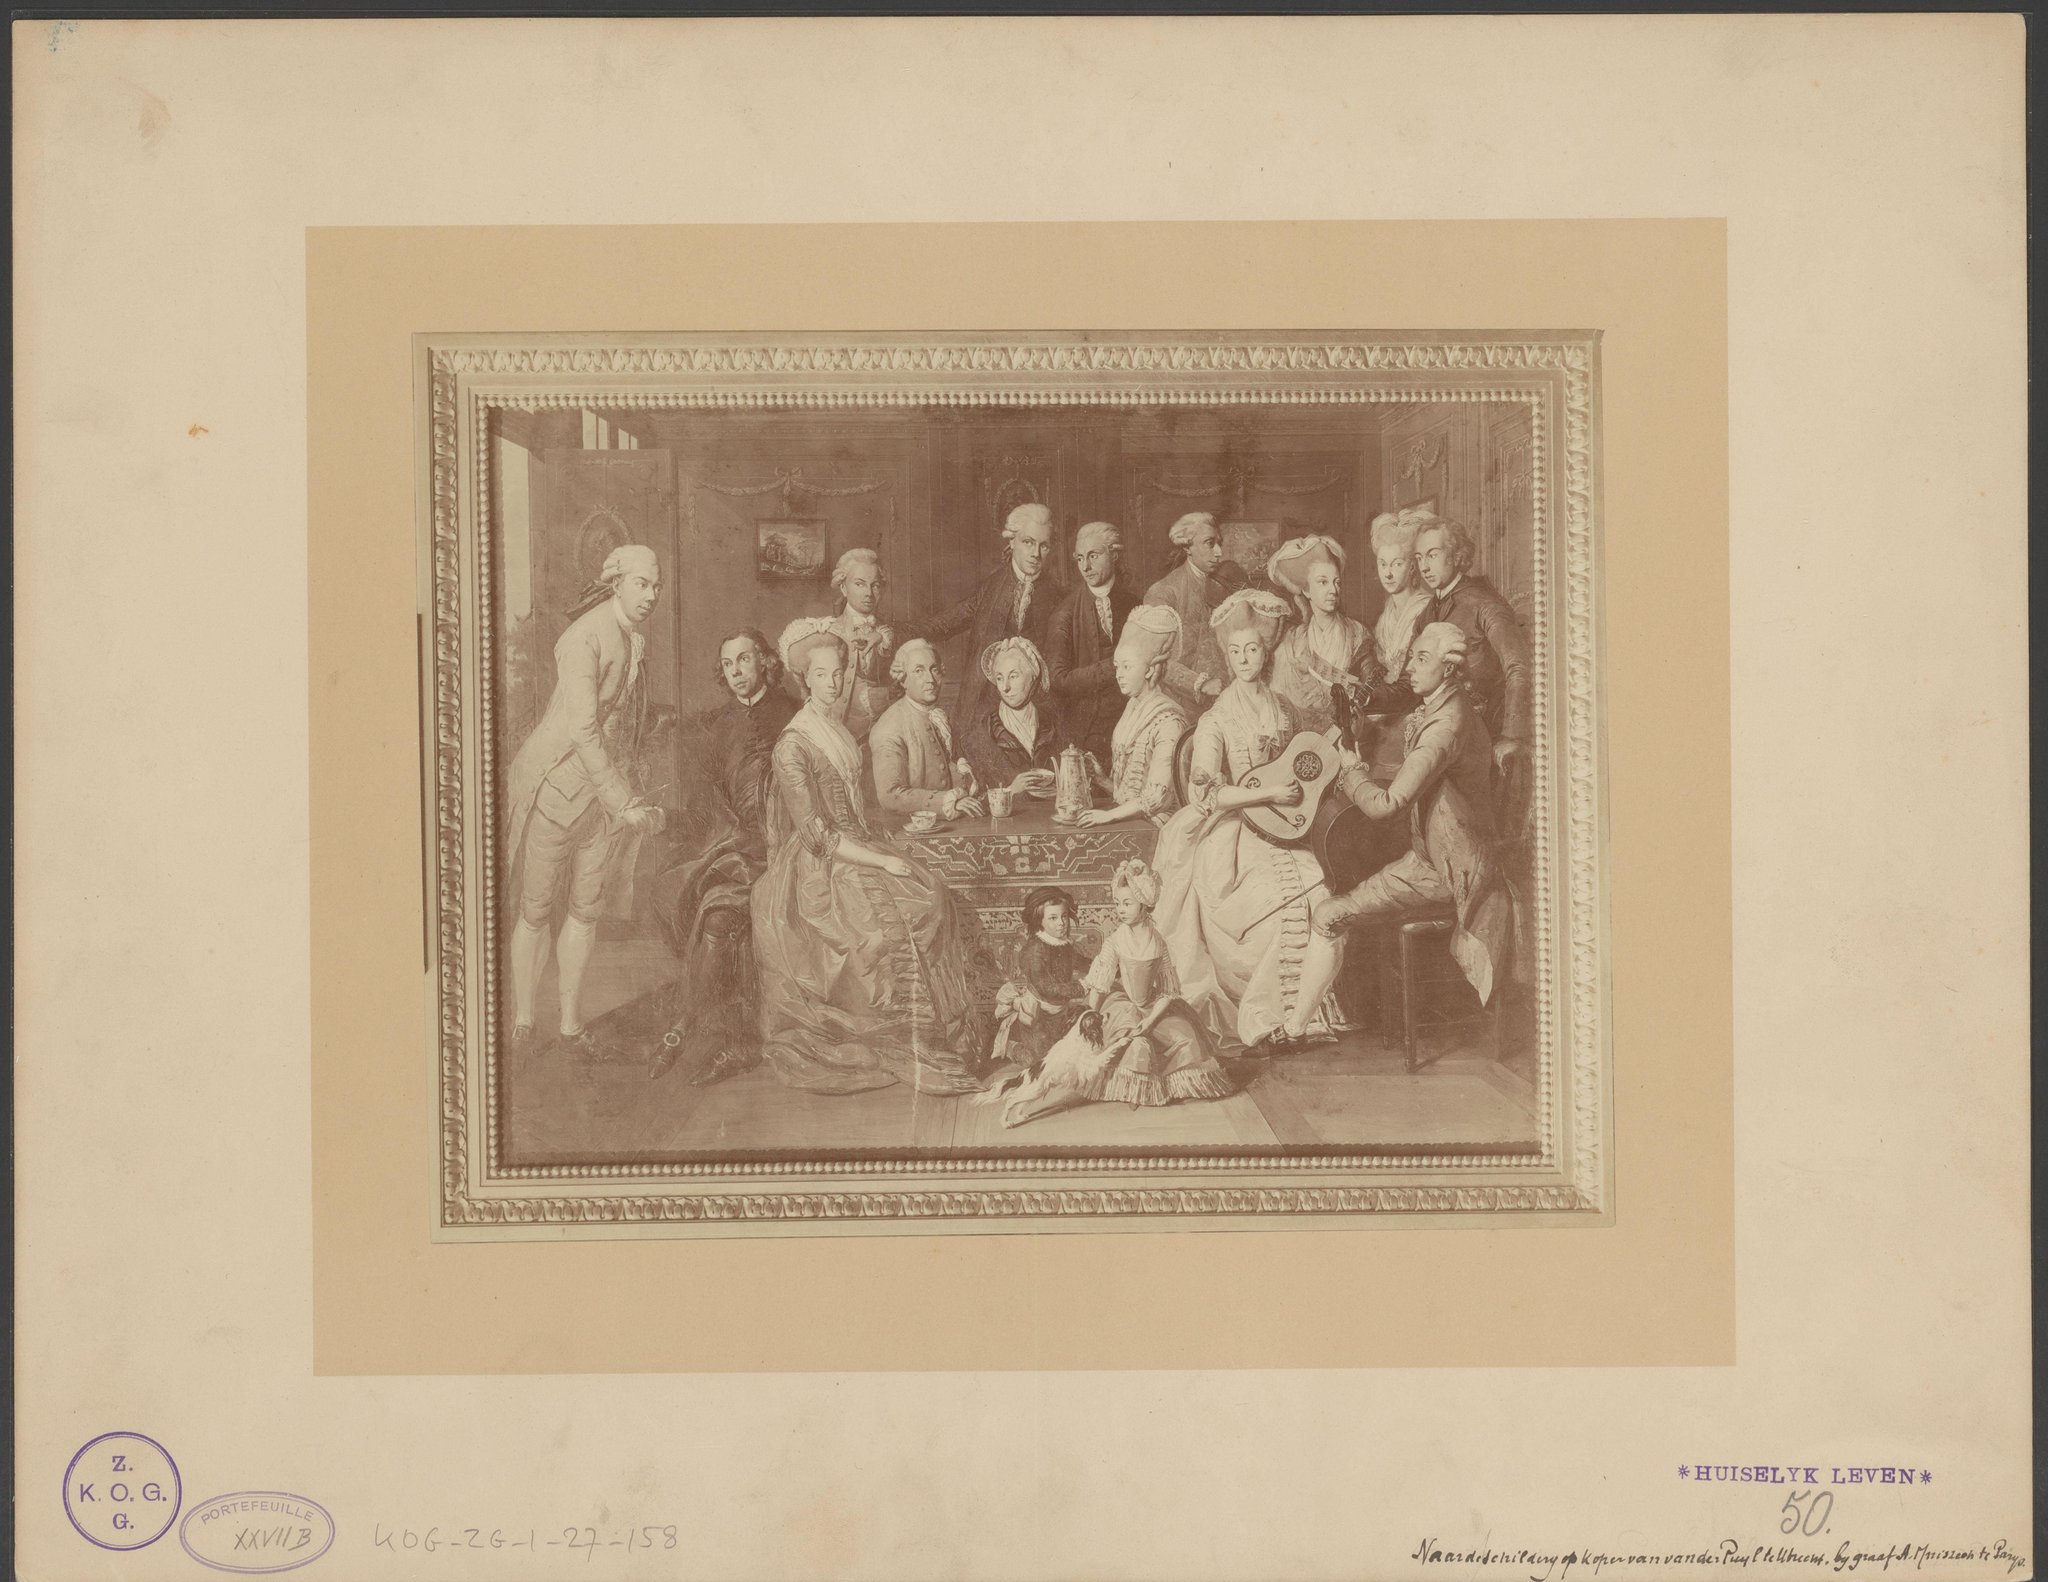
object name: reproduction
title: Fotoreproductie van schilderij met familieportret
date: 1870-1910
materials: cardboard, photographic support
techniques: albumen print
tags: communal rooms, family life at home, afternoon tea, dog, more than one musician with instrument, anonymous historical persons portrayed in a group, in a group-portrait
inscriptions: collector's mark: Lugt 1641, collector's mark:, collector's mark: Lugt 963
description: Volgens notitie op het karton is de foto naar een schilderij op koper, in het bezit van graaf A. Muislech (?) te Parijs.